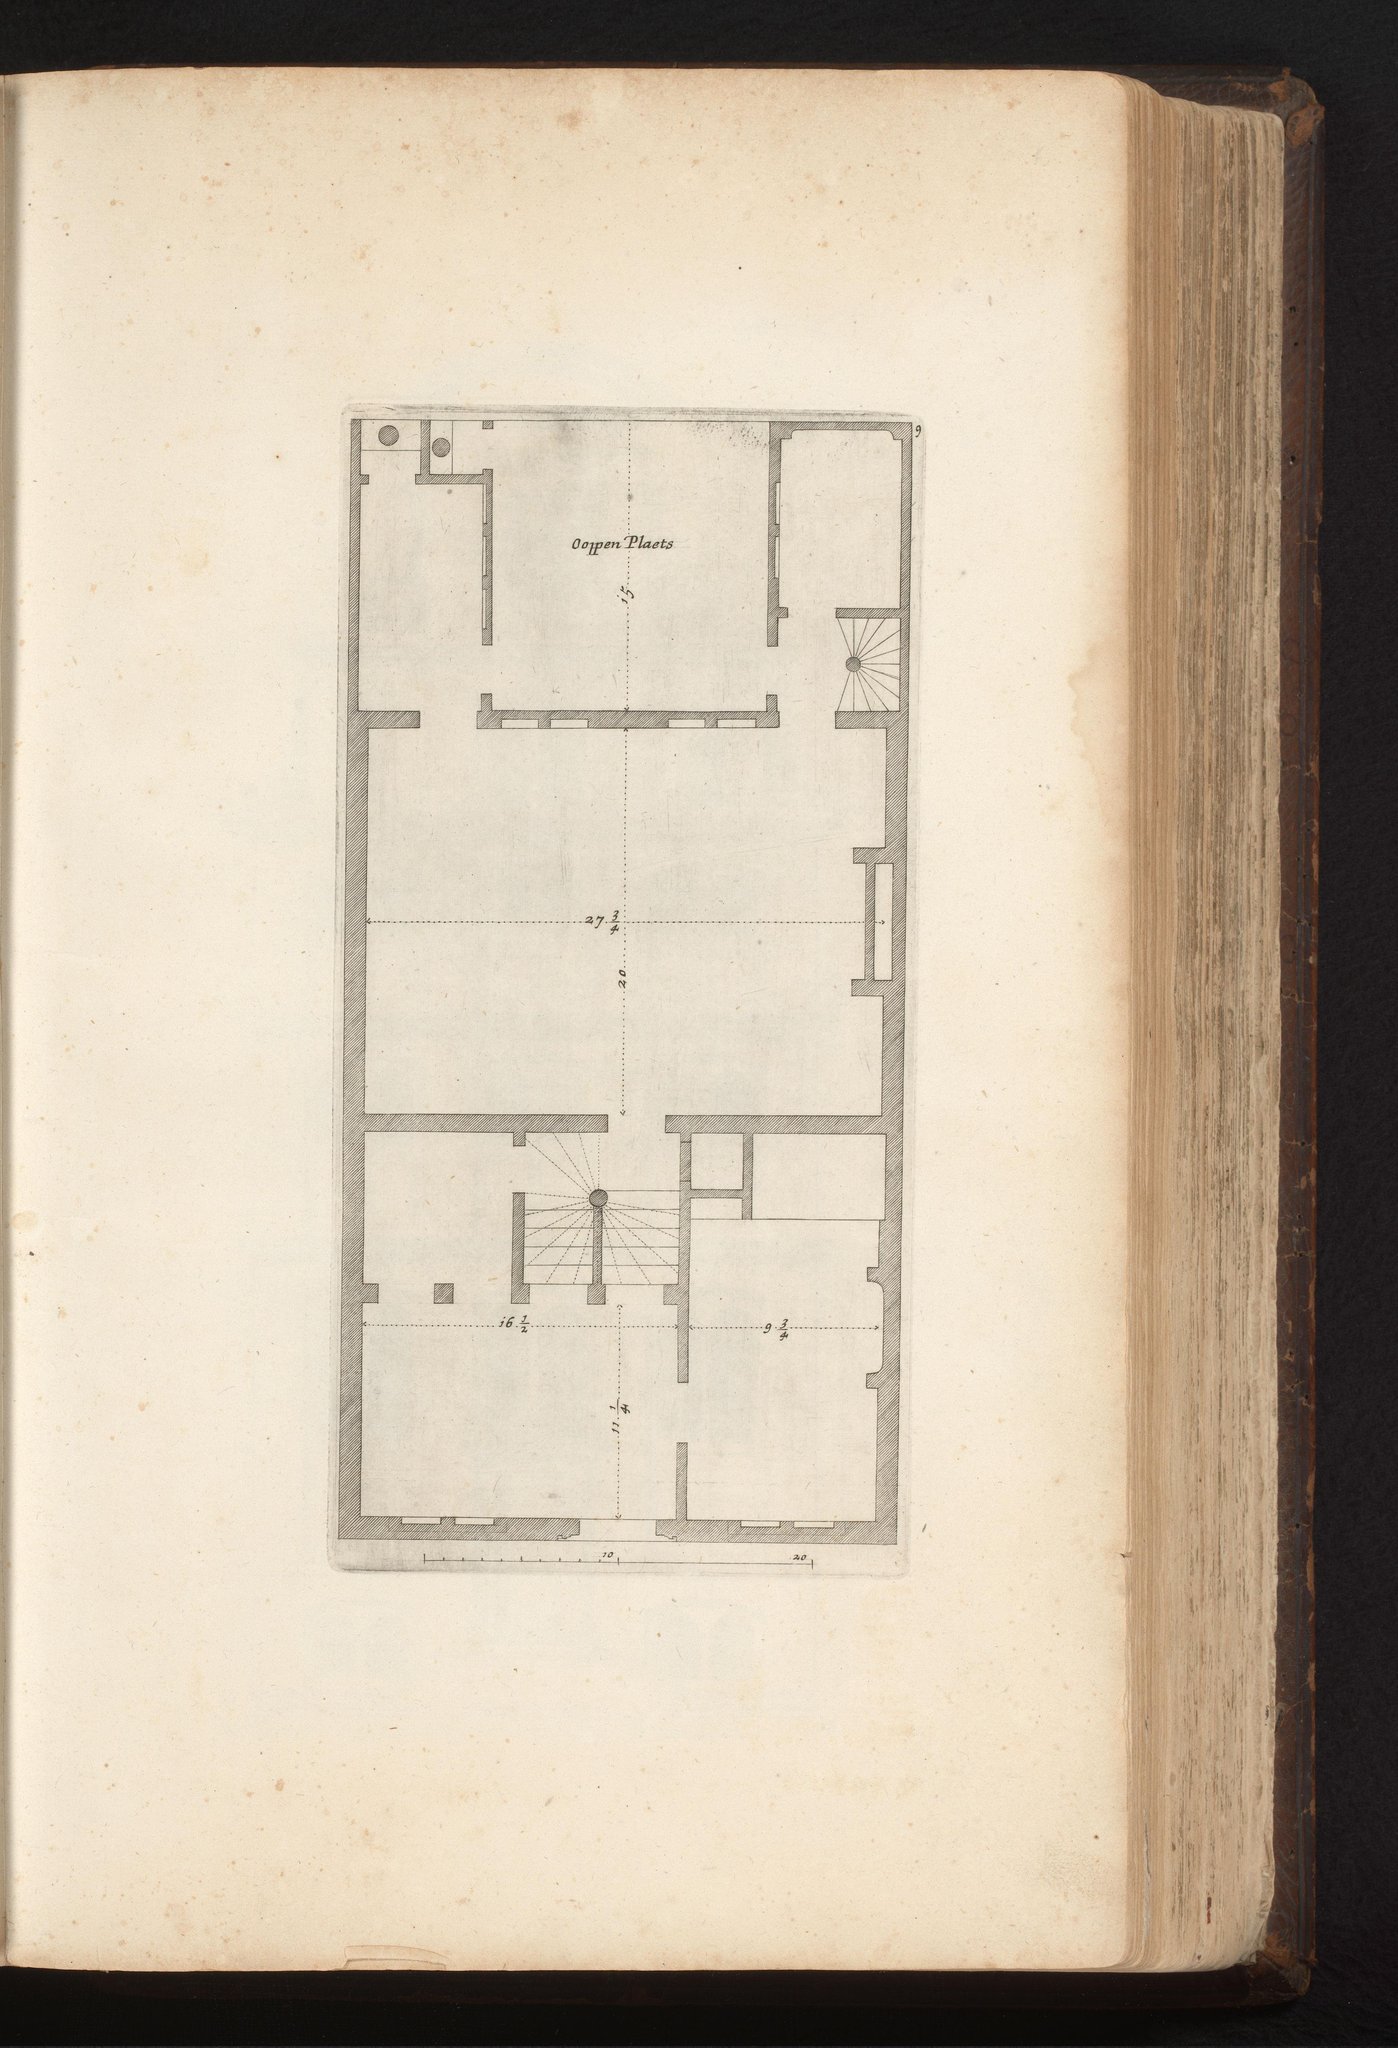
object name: book illustration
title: Plattegrond voor een huis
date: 1648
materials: paper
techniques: engraving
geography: amsterdam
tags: plan ~ architecture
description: Prent uit: Afbeelsels der voornaemste gebouwen uyt alle die Philips Vingboons geordineert heeft. Amsterdam: Philips en Johannes Vinckboons en Johannes Willemszoon Blaeu, 1648.